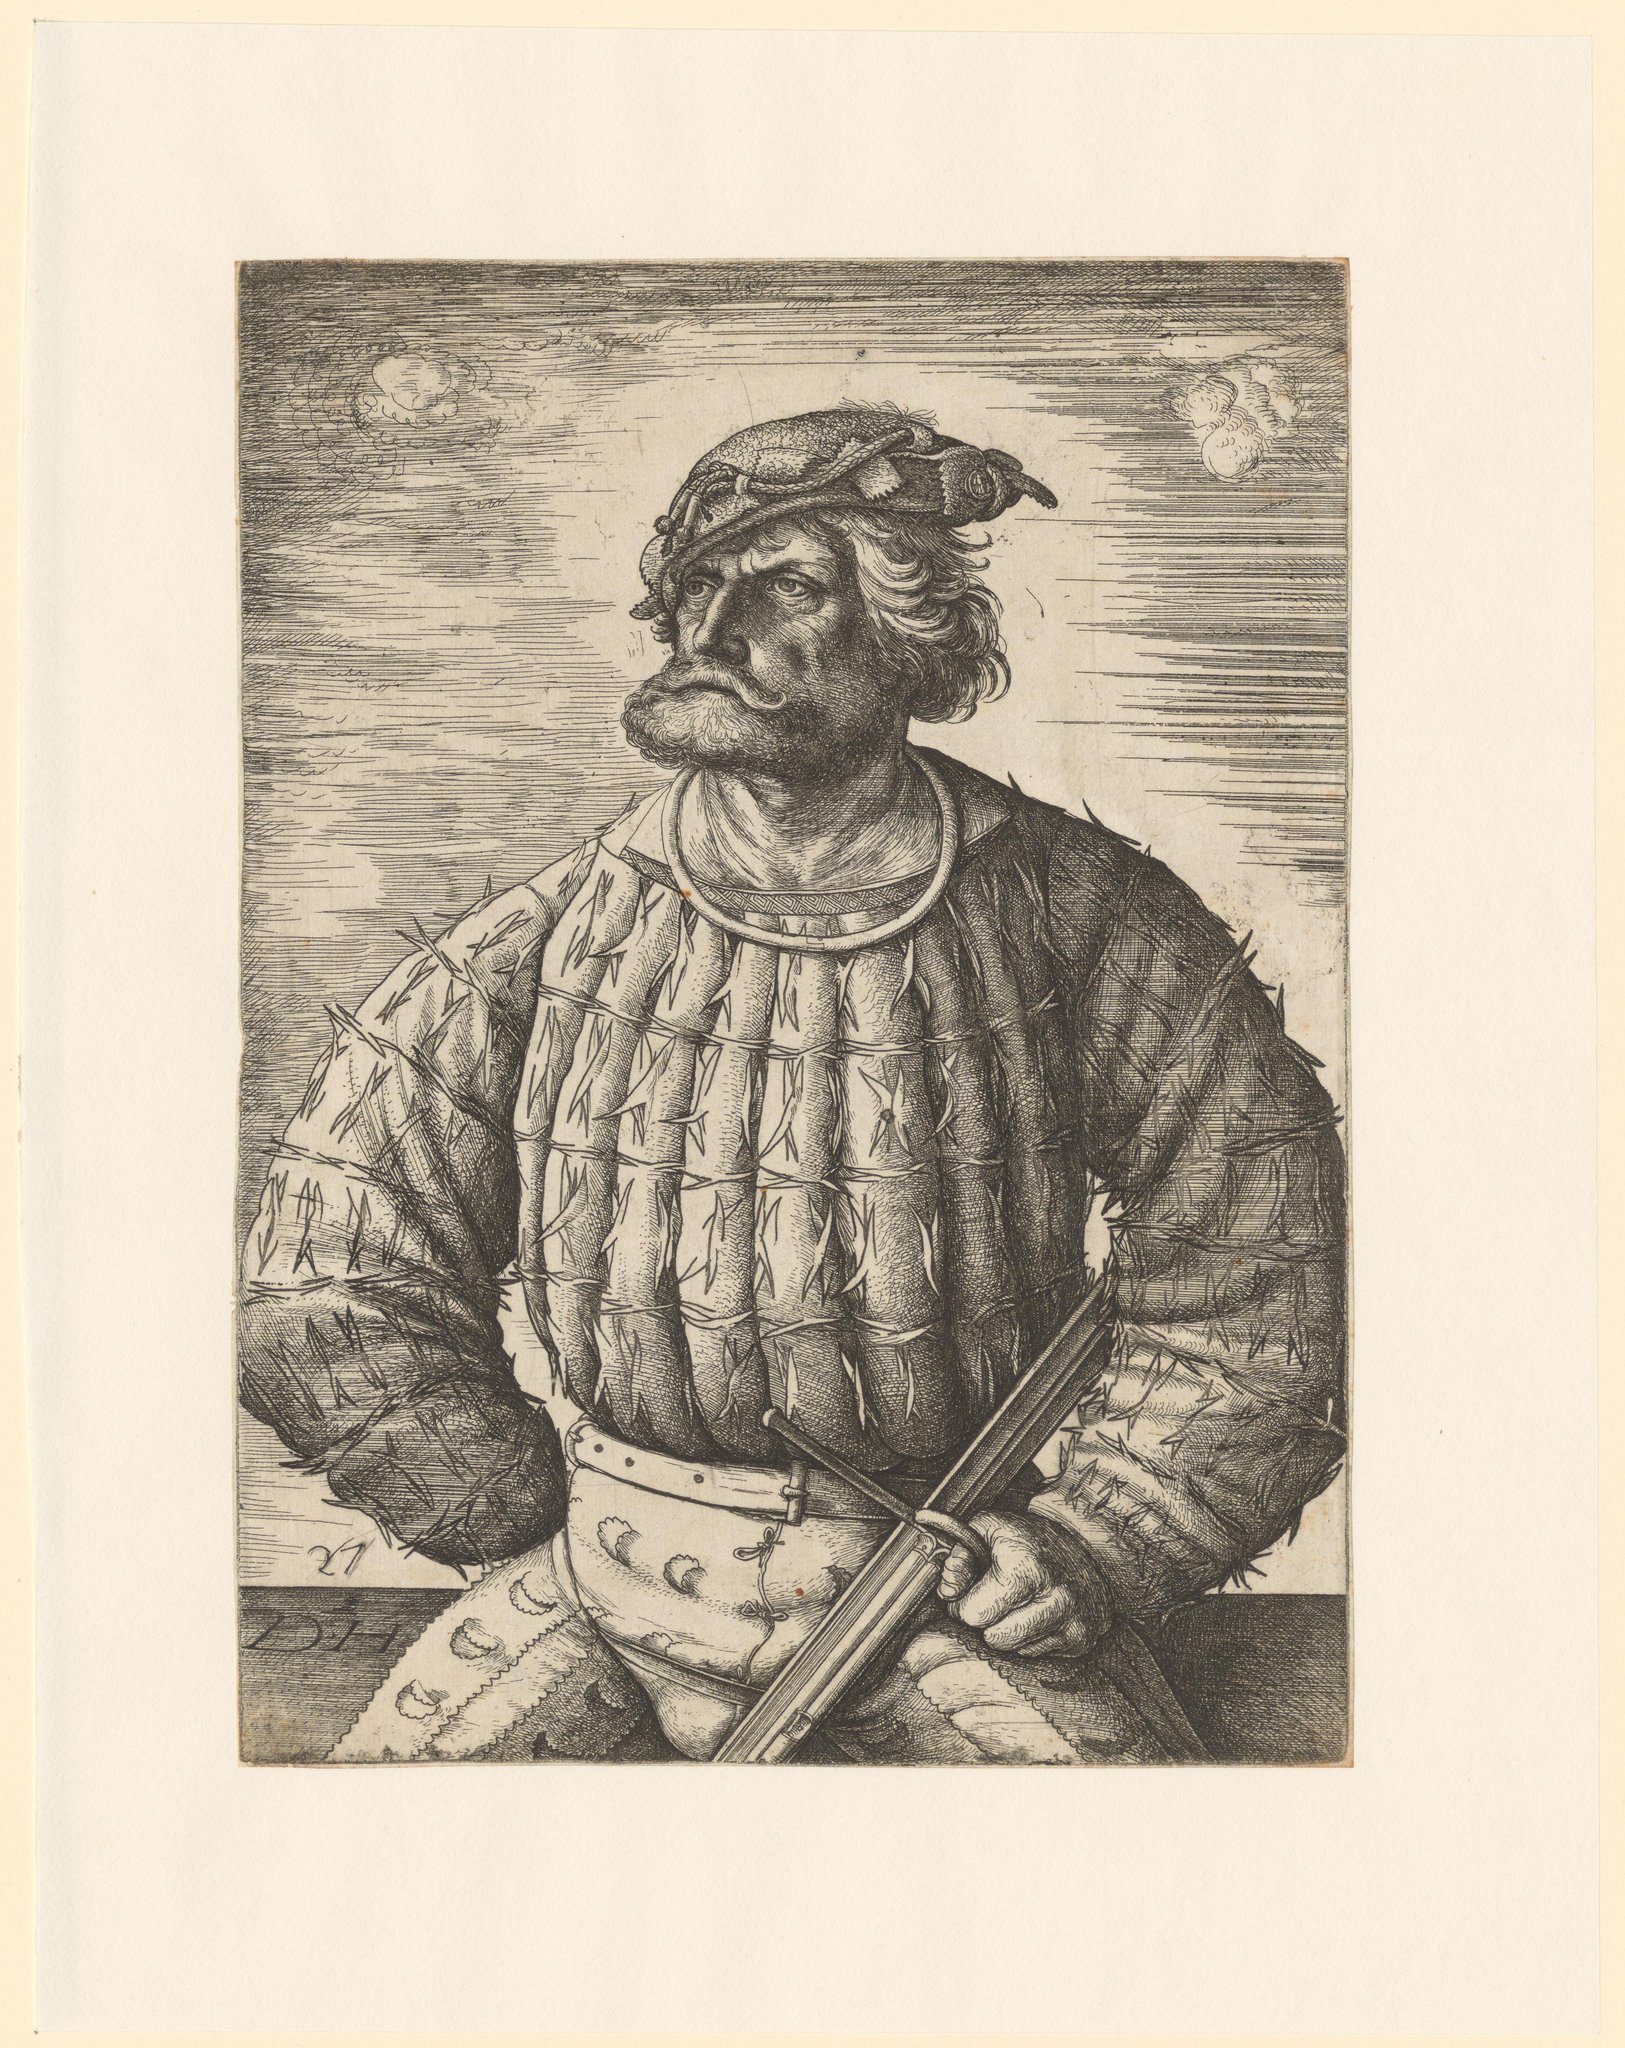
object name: print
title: Portret van Kunz von der Rosen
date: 1504-1536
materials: paper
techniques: etching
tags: court jester, court fool, historical persons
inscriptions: collector's mark: Lugt 2228, collector's mark: Lugt 240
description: David Funck (1642-1709) kocht 230 ijzeren platen van de prentenmakers uit de familie Hopfer aan, nummerde deze (nu bekend als het Funck nummer) en herdrukte de verder onaangetaste platen onder de titel Operae Hopferianae in 1684 in Neurenberg. (Metzger, 2009)